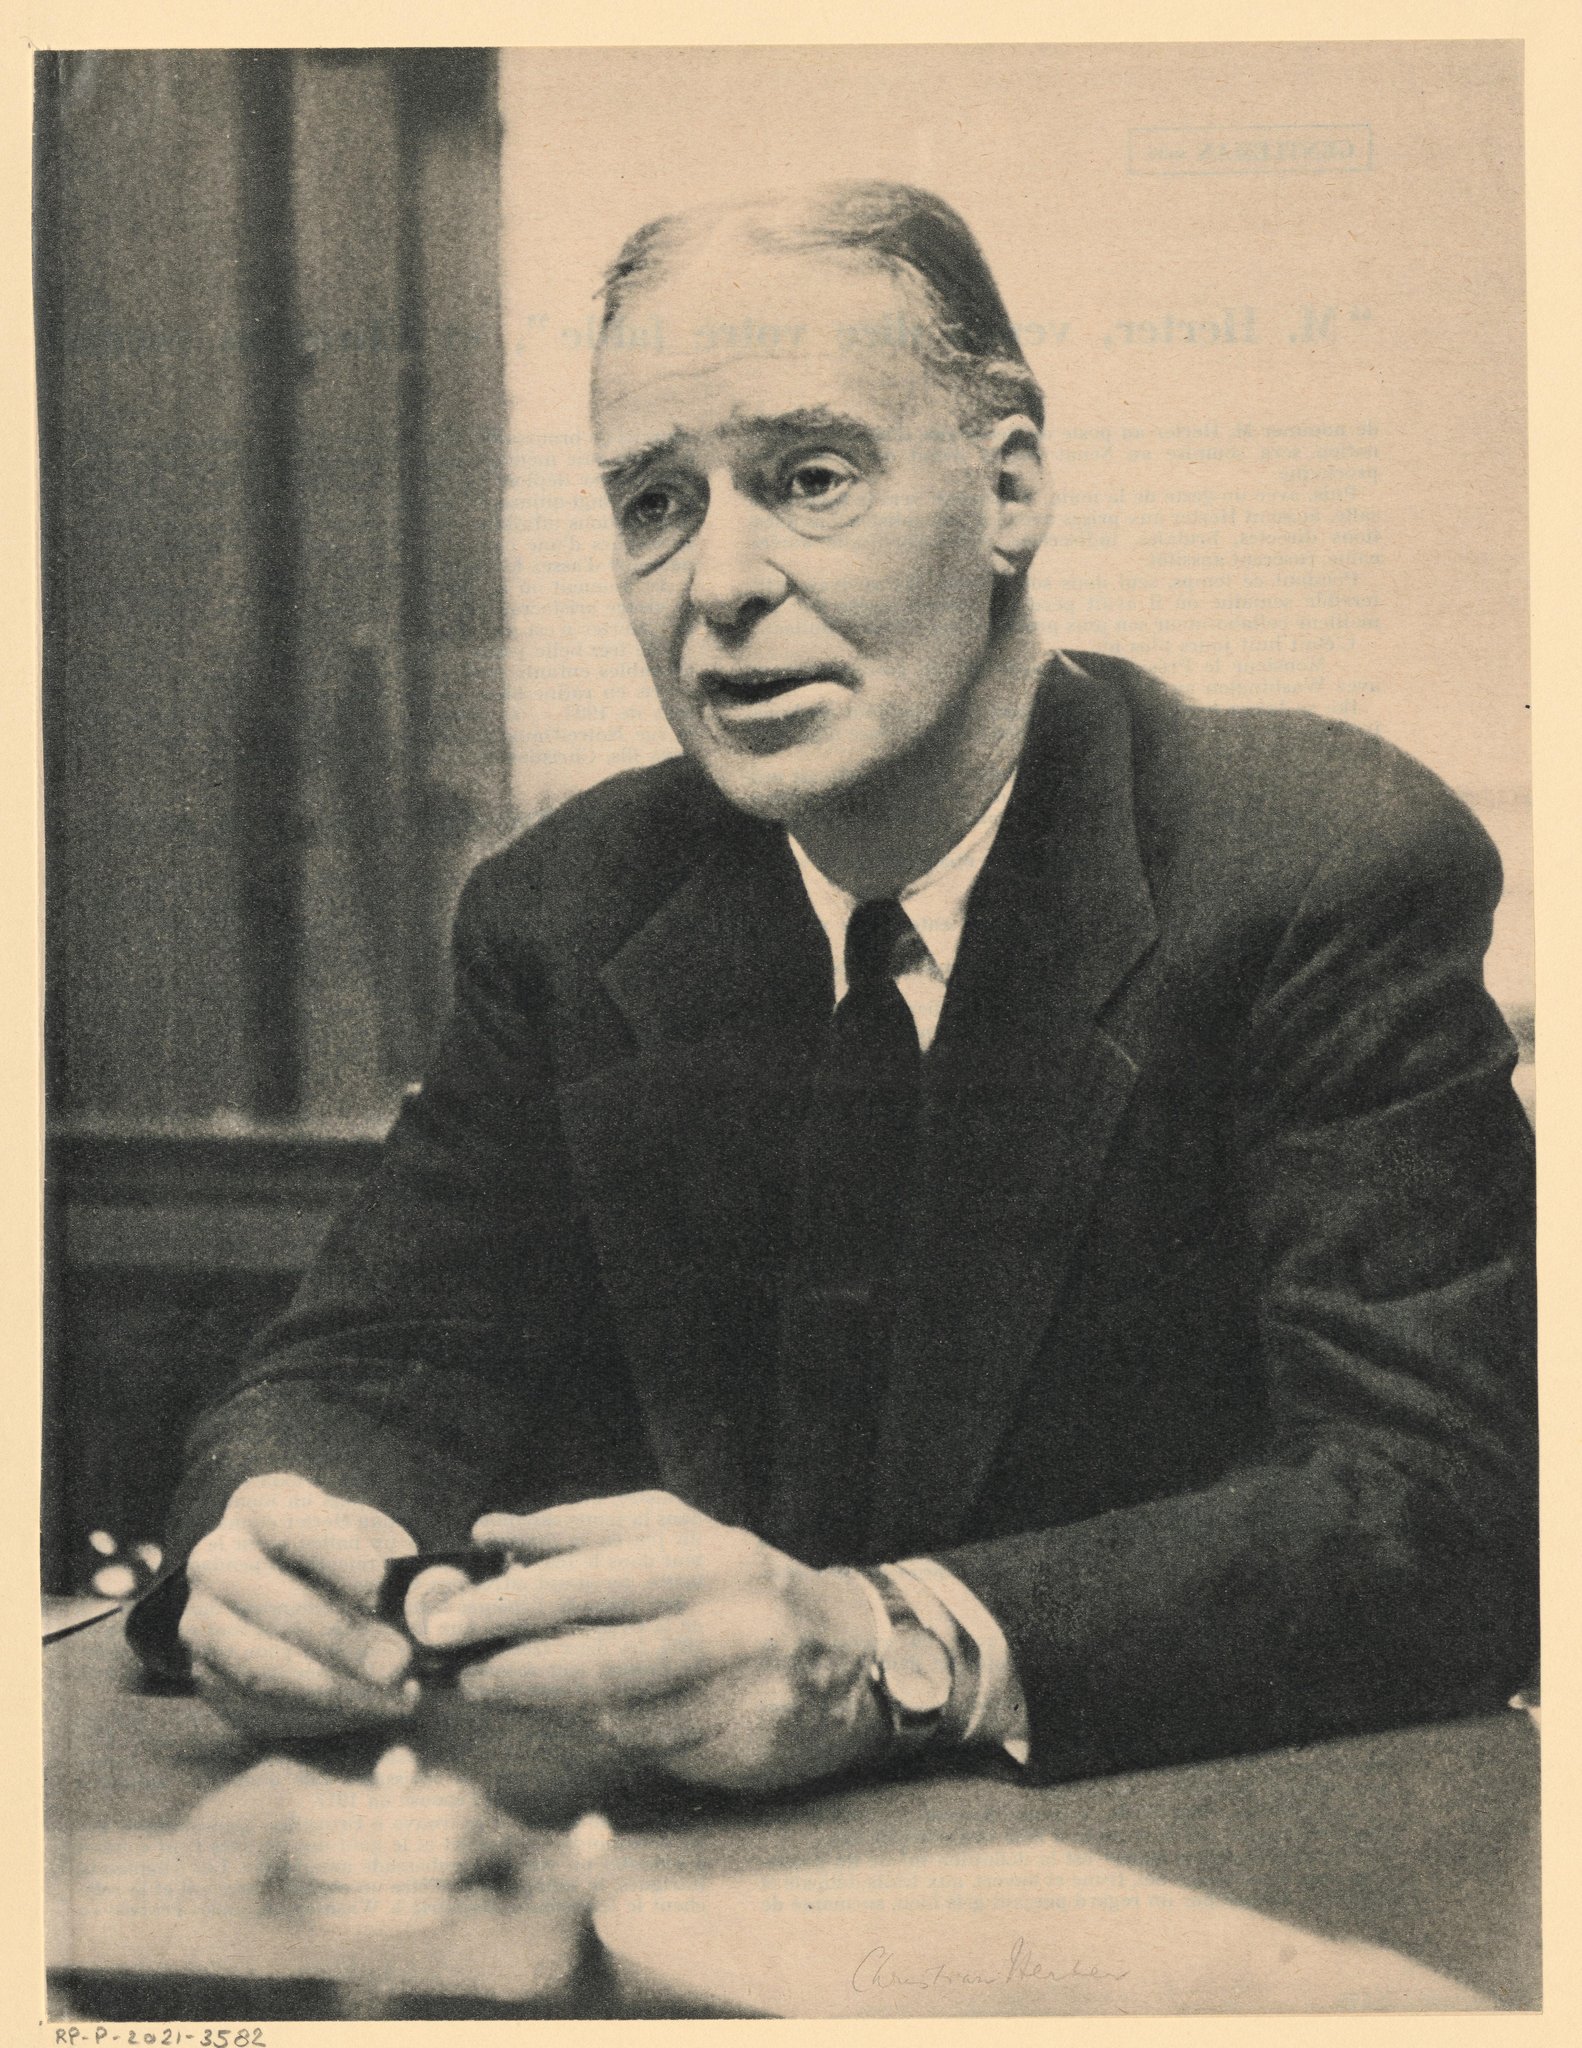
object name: photomechanical print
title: Portret van Christian Herter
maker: Anonymous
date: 1959-1960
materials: paper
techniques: letterpress printing, rotogravure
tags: paris, politician, historical persons, politician, e.g. party leader